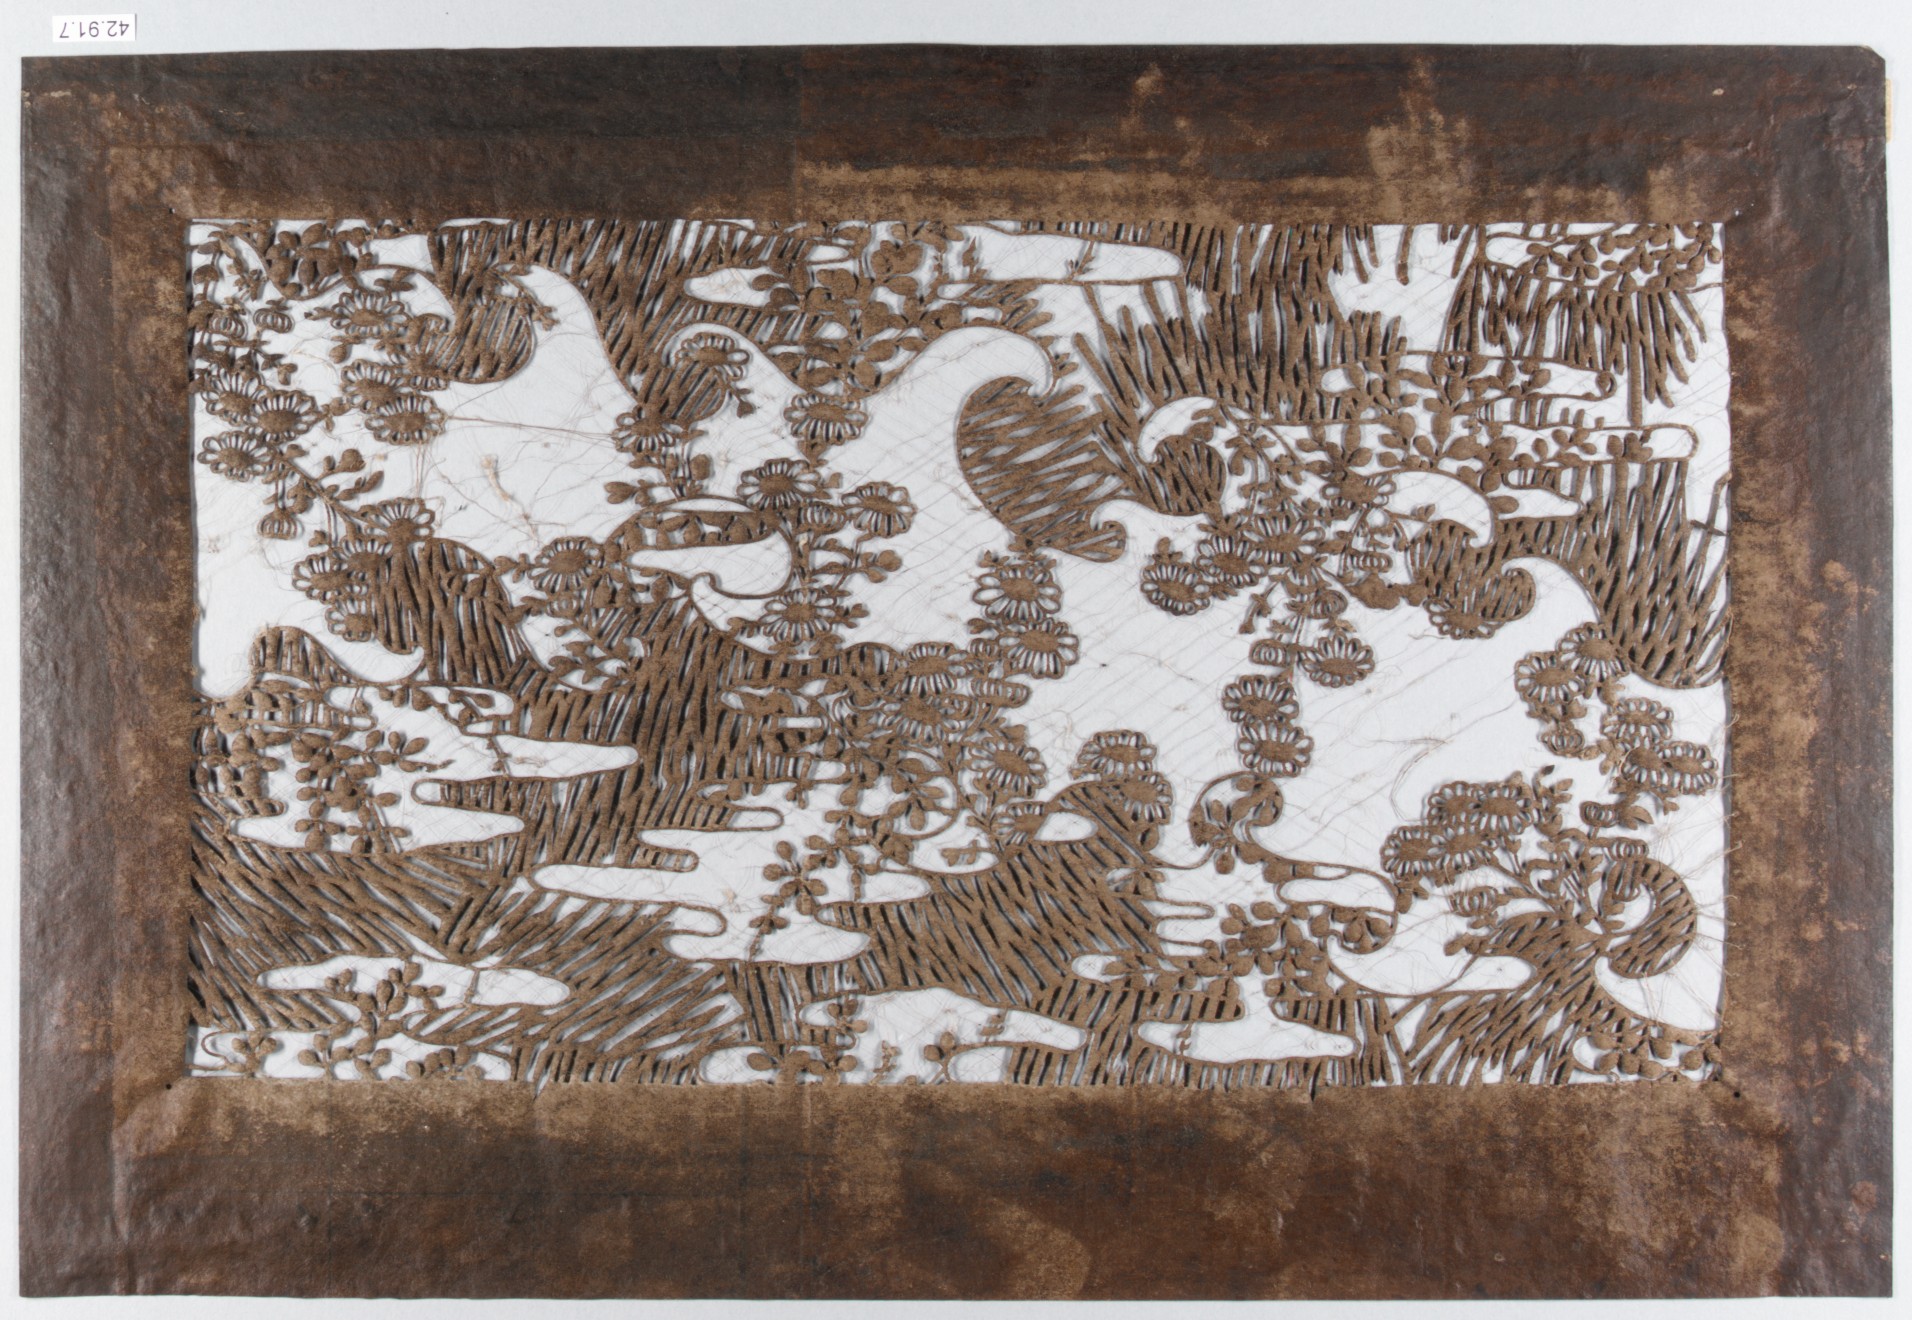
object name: stencil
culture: japanese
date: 1801-1900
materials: paper, silk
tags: flowers